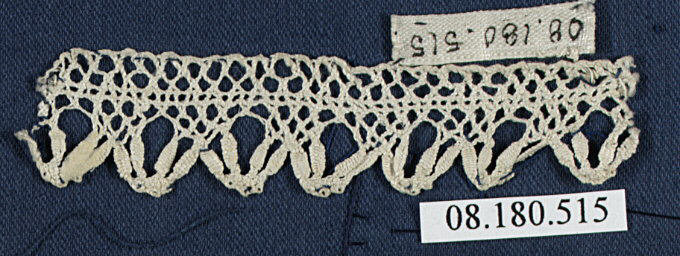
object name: fragment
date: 1501-1600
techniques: lace